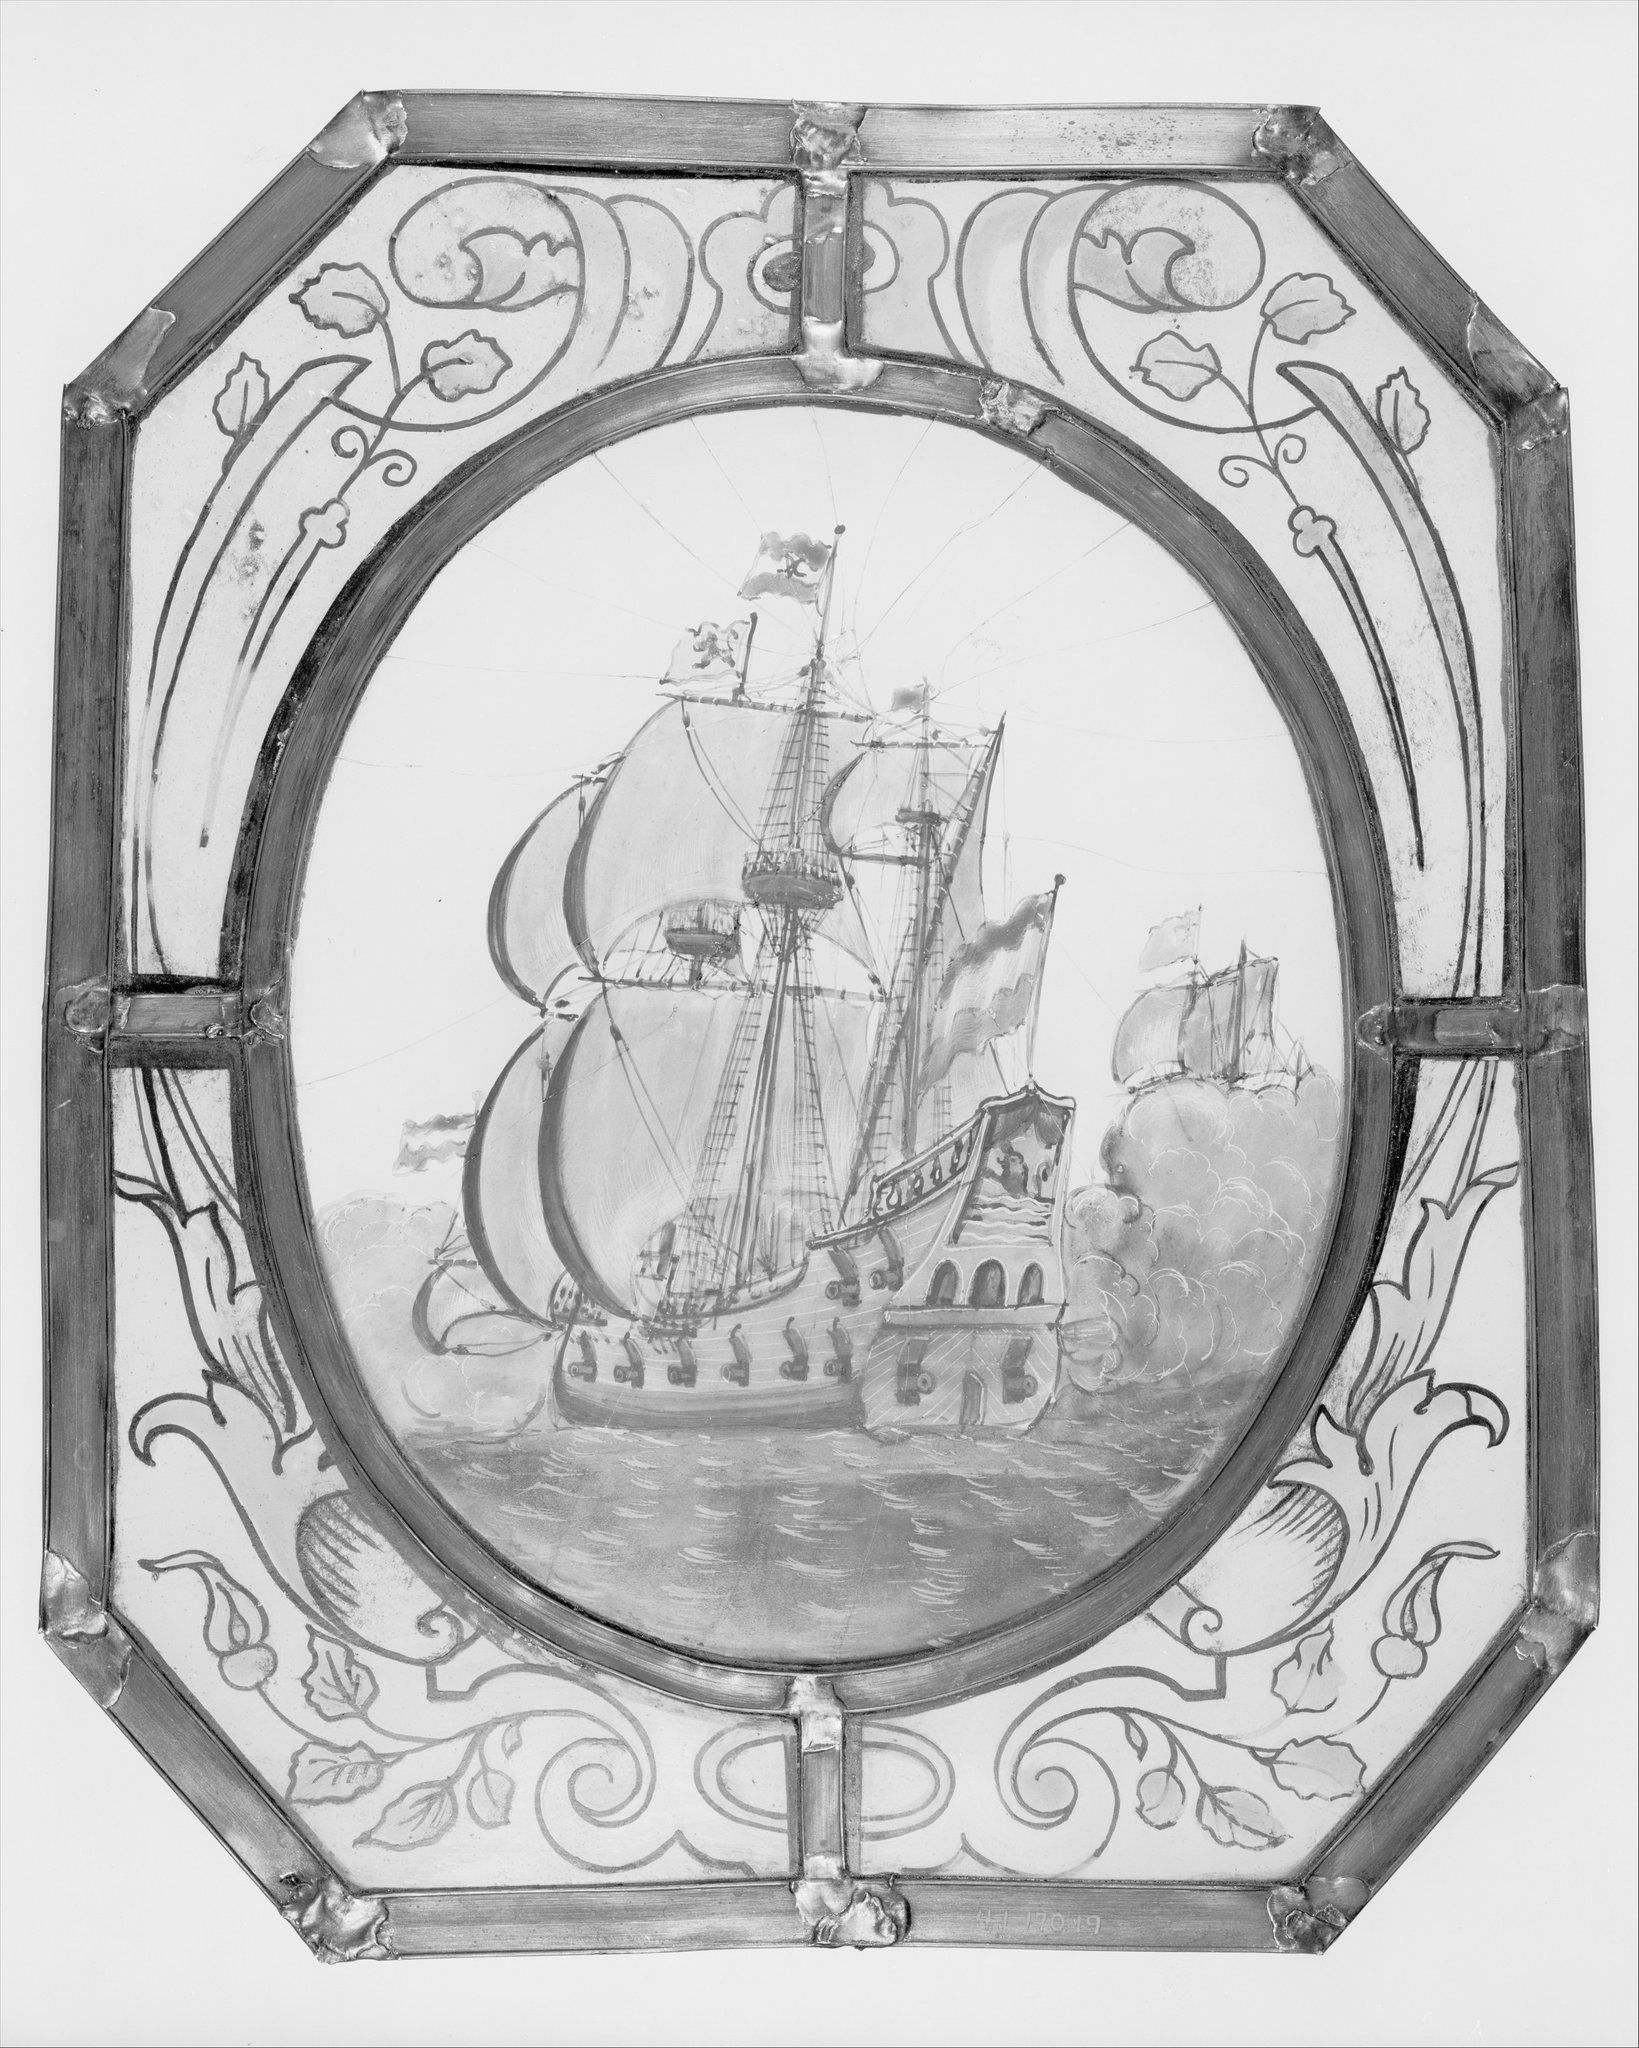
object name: panel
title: Battle with two warships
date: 1601-1650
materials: glass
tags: battles,ships